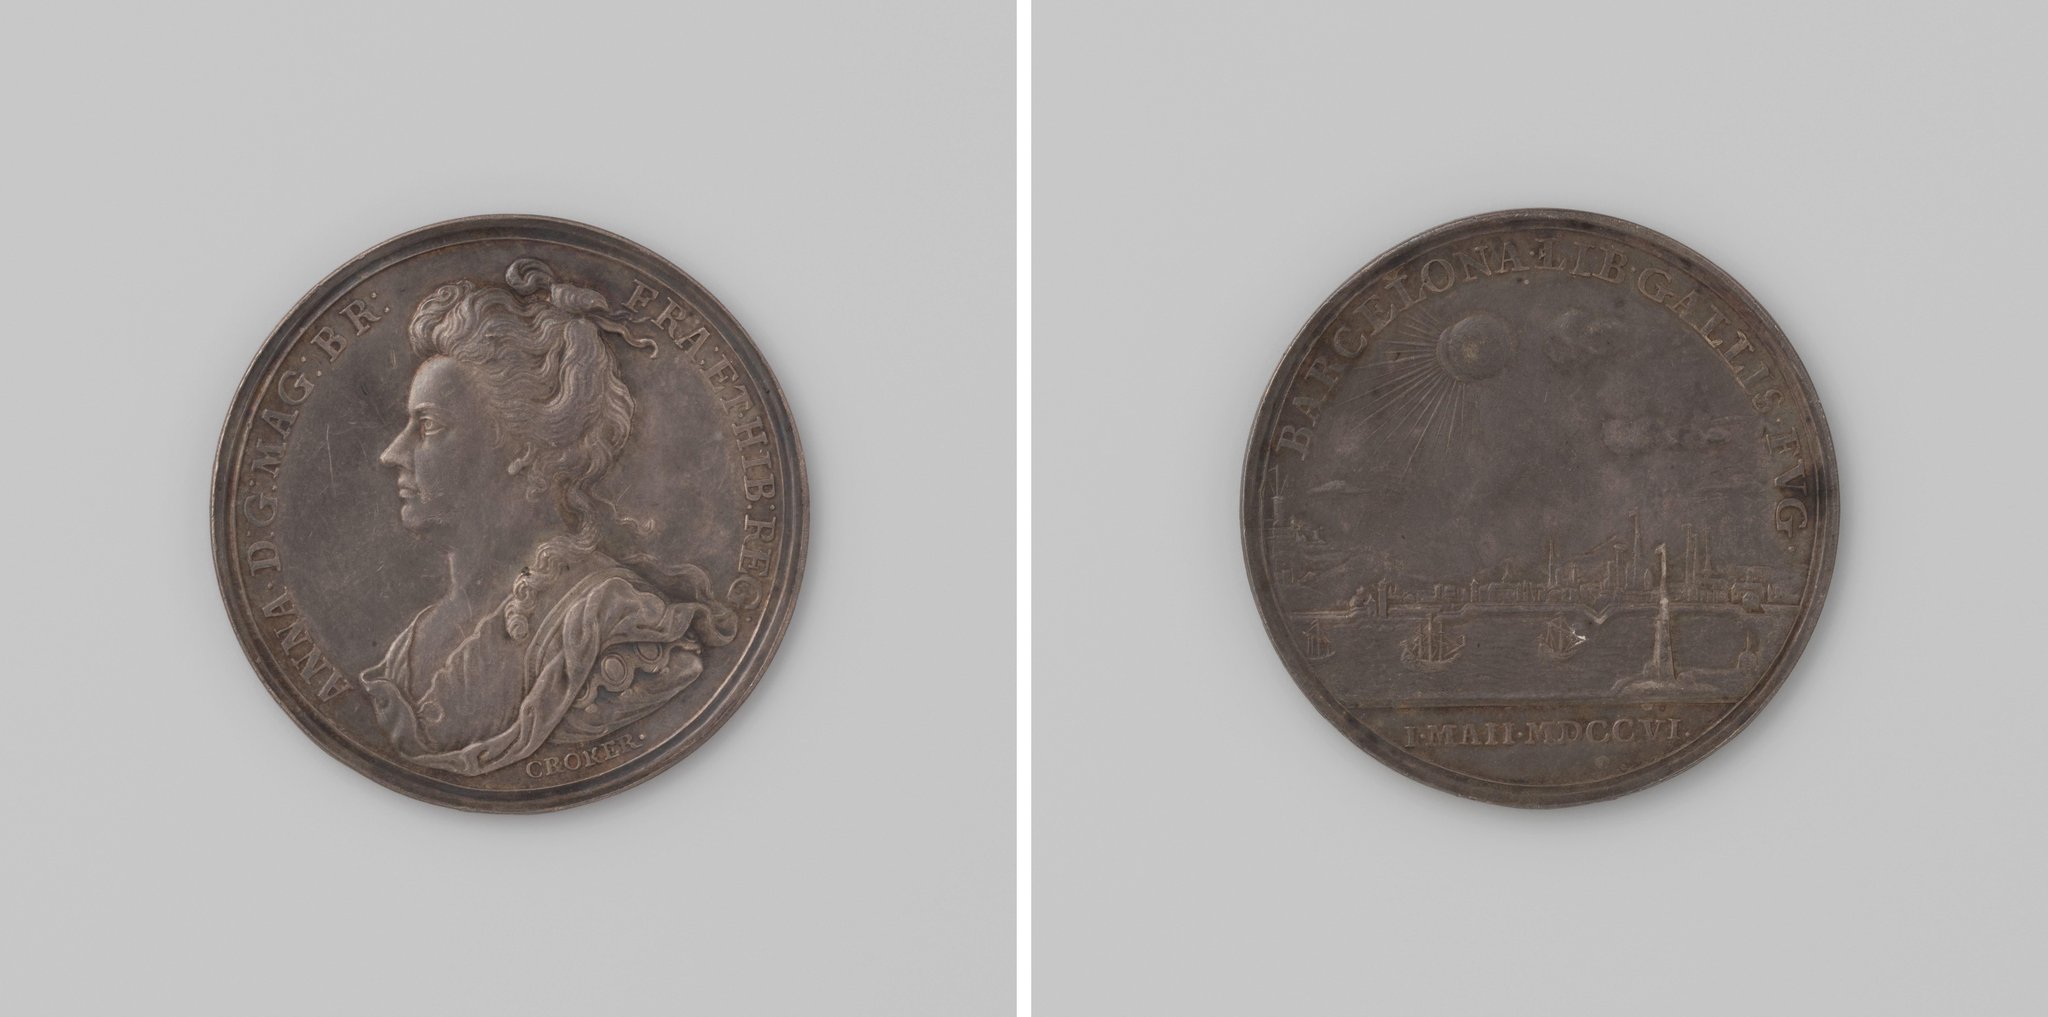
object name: history medal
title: Ontzet van Barcelona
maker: john croker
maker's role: die cutter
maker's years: 1670-1741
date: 1706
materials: silver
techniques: striking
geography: london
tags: anna stuart (koningin van engeland en schotland)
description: Zilveren penning. Voorzijde: borststuk vrouw binnen omschrift. Keerzijde: gezicht op stad Barcelona en haven, tijdens zonsverduistering binnen omschrift; afsnede: datering.